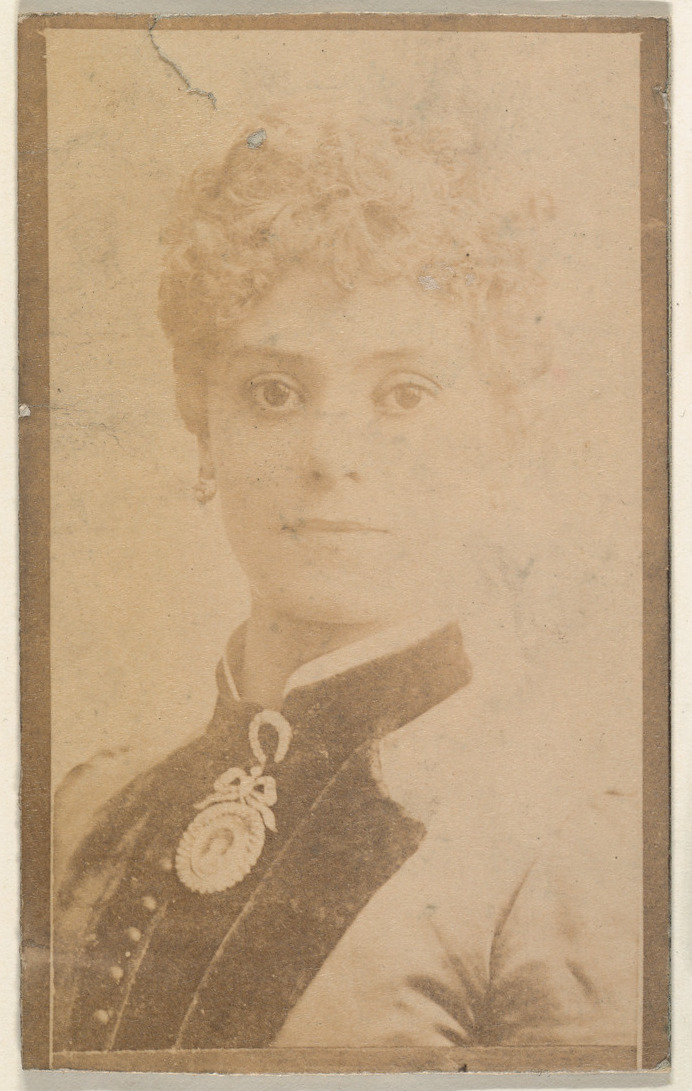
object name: photograph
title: Portrait of actress wearing large brooch, from the Actresses series (N668)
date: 1888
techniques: albumen silver print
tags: portraits,women,actresses